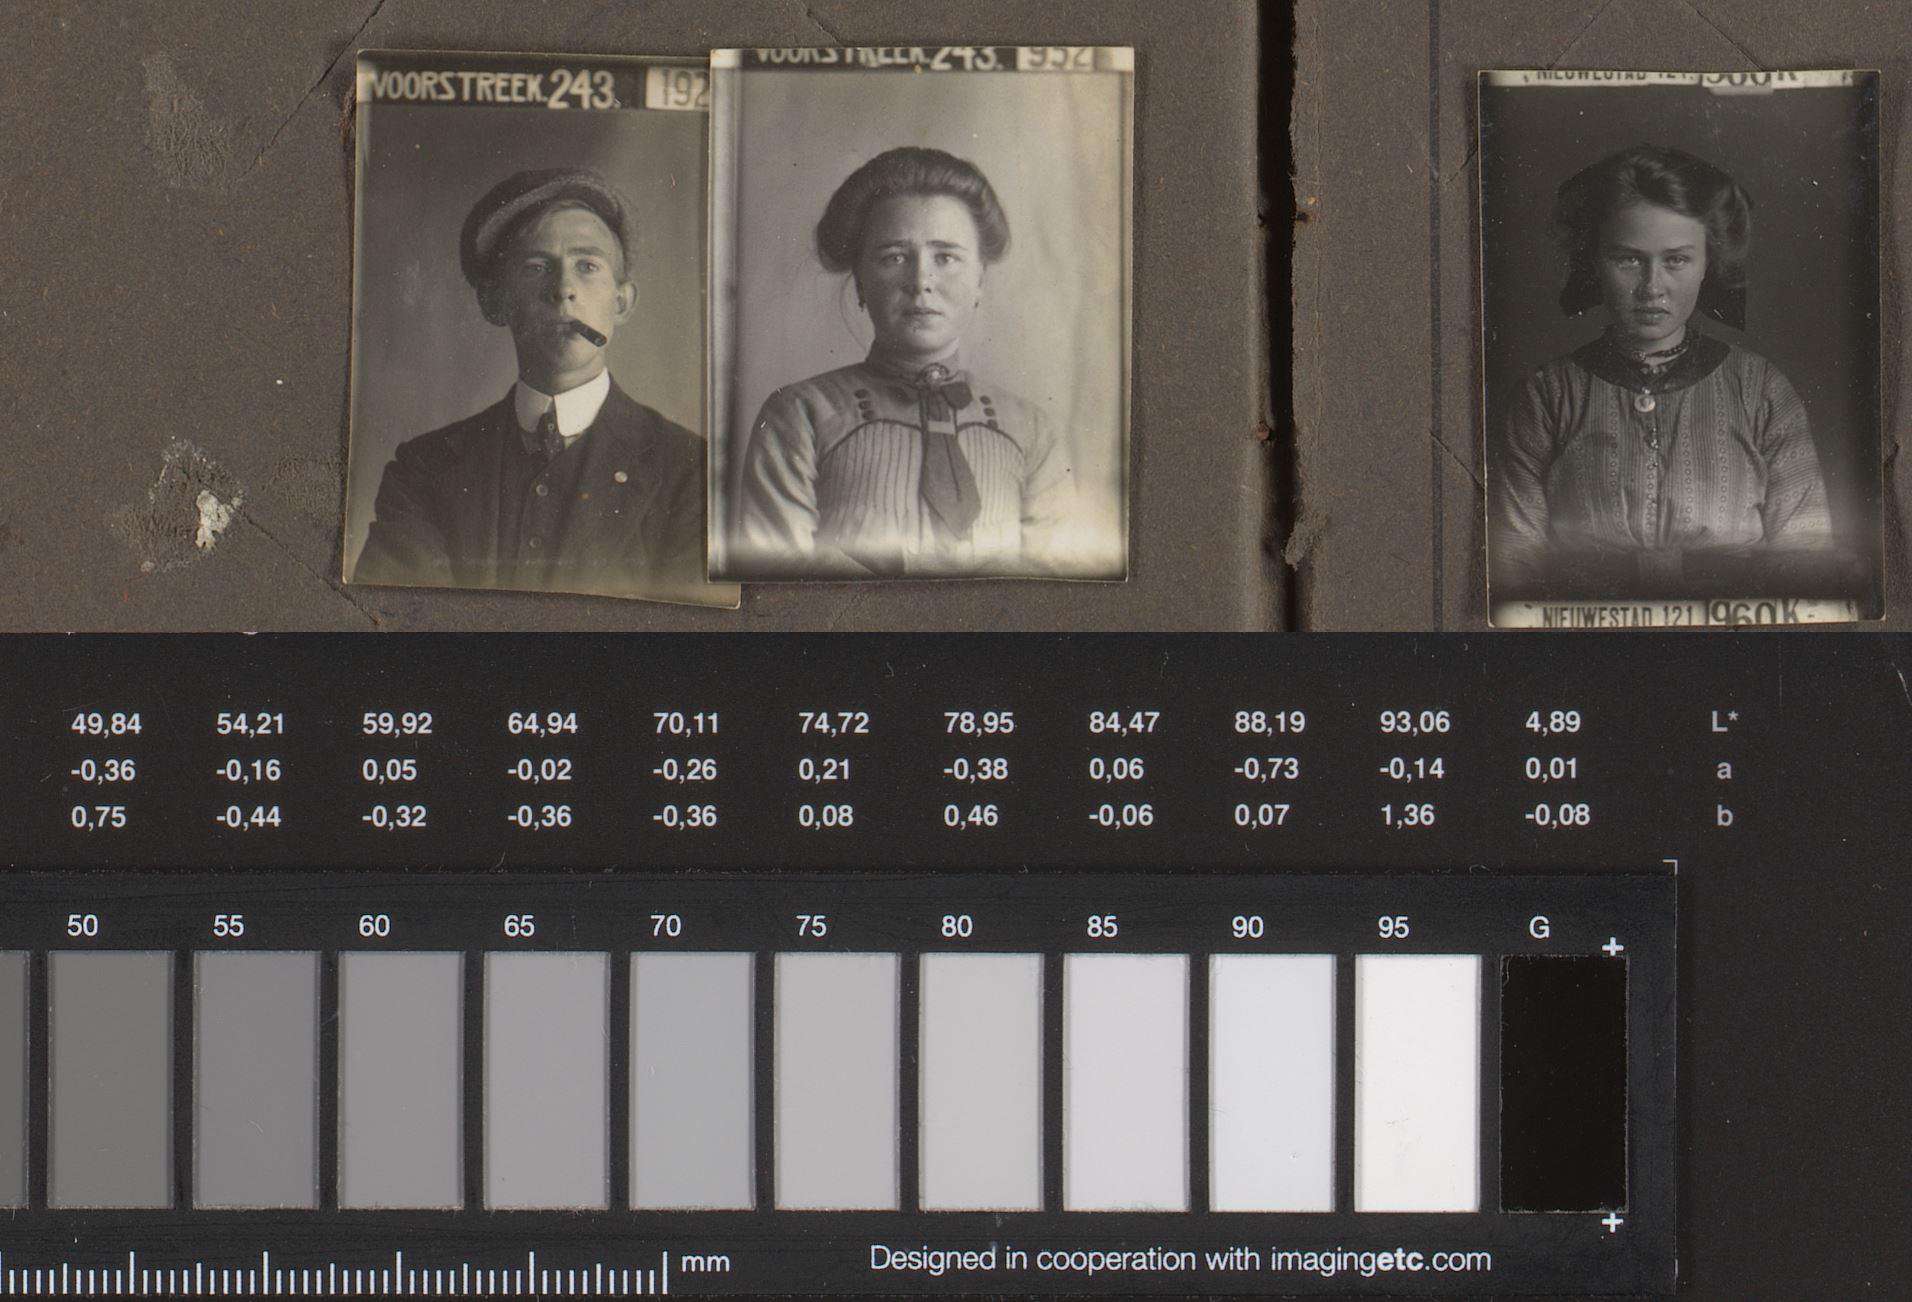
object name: album leaf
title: Portret van een onbekende jonge vrouw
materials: paper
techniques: gelatin silver print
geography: leeuwarden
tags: anonymous historical person portrayed - bb - woman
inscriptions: address: ‘VOORSTREEK 243./ 952’